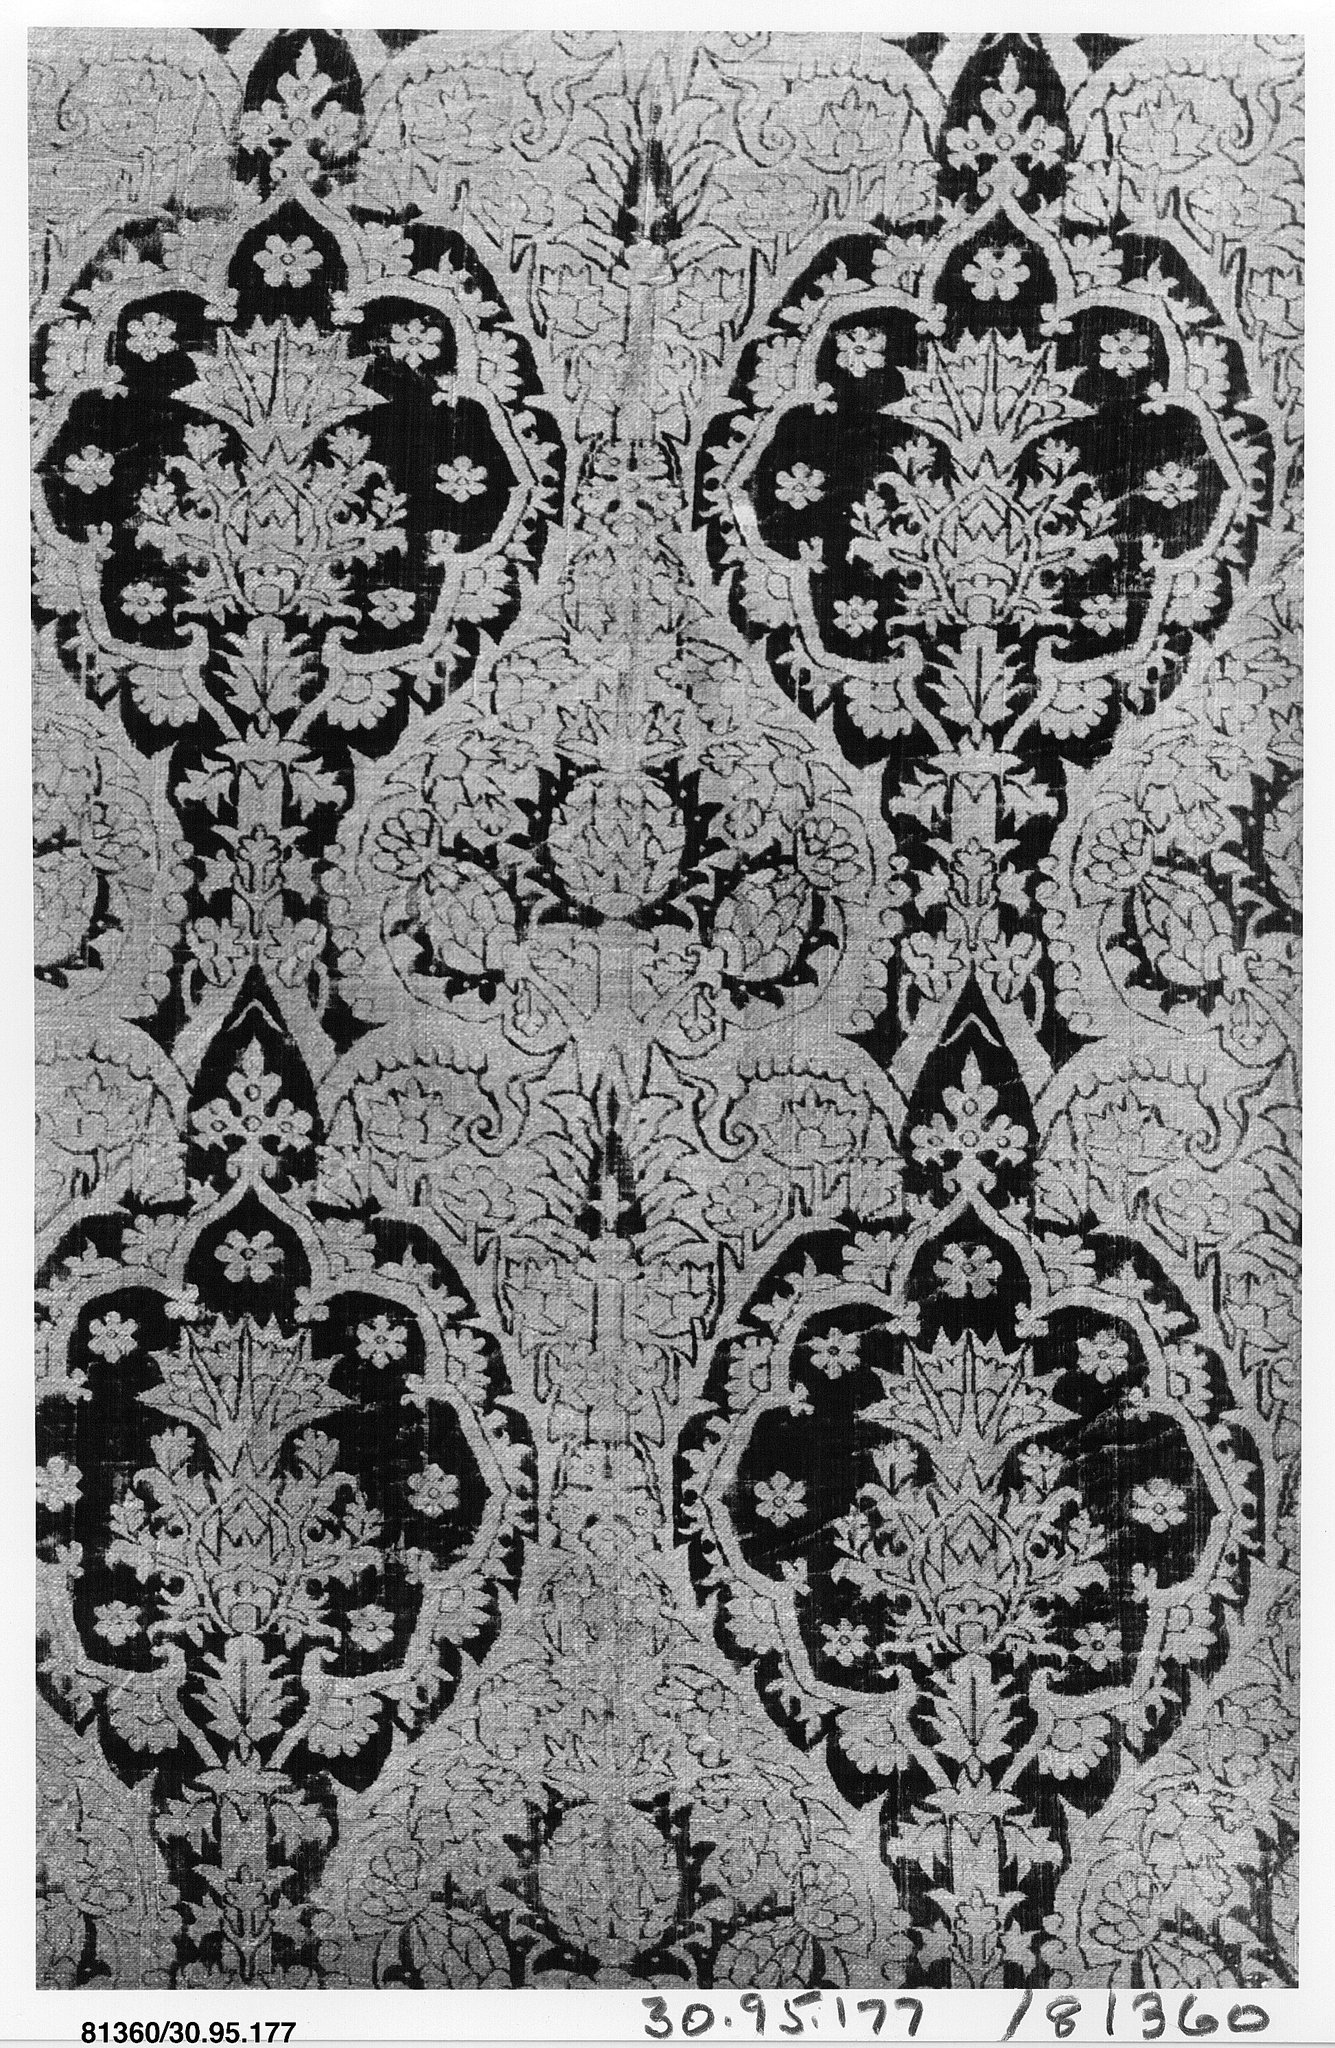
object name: panel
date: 1500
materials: silk, thread